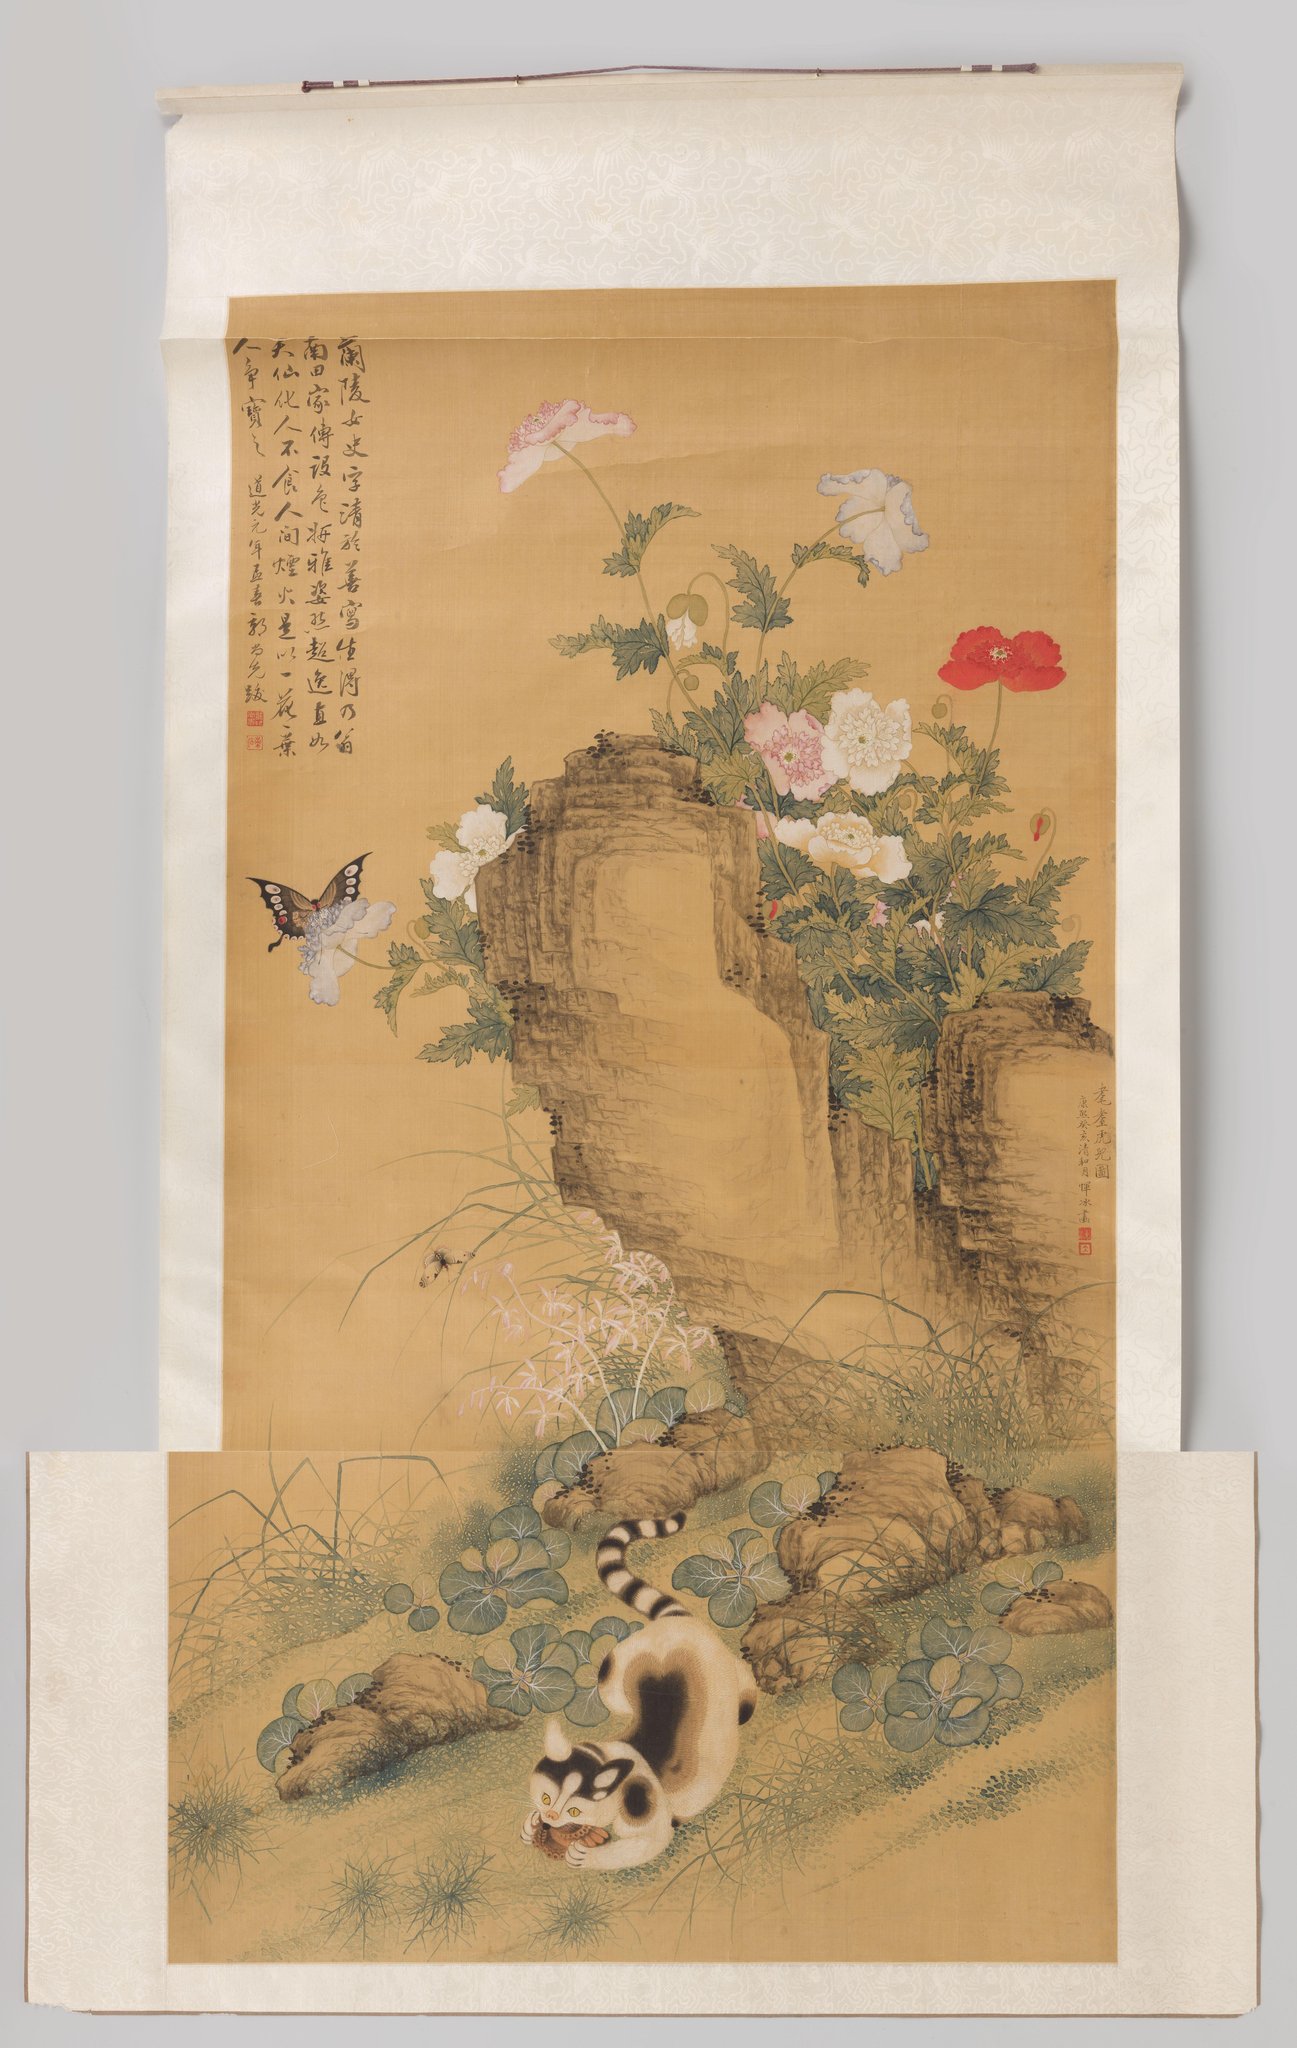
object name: hanging scroll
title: Hangrol met papavers, vlinders en een kat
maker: yun bing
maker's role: painter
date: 1683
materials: ink, silk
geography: changzhou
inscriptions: date